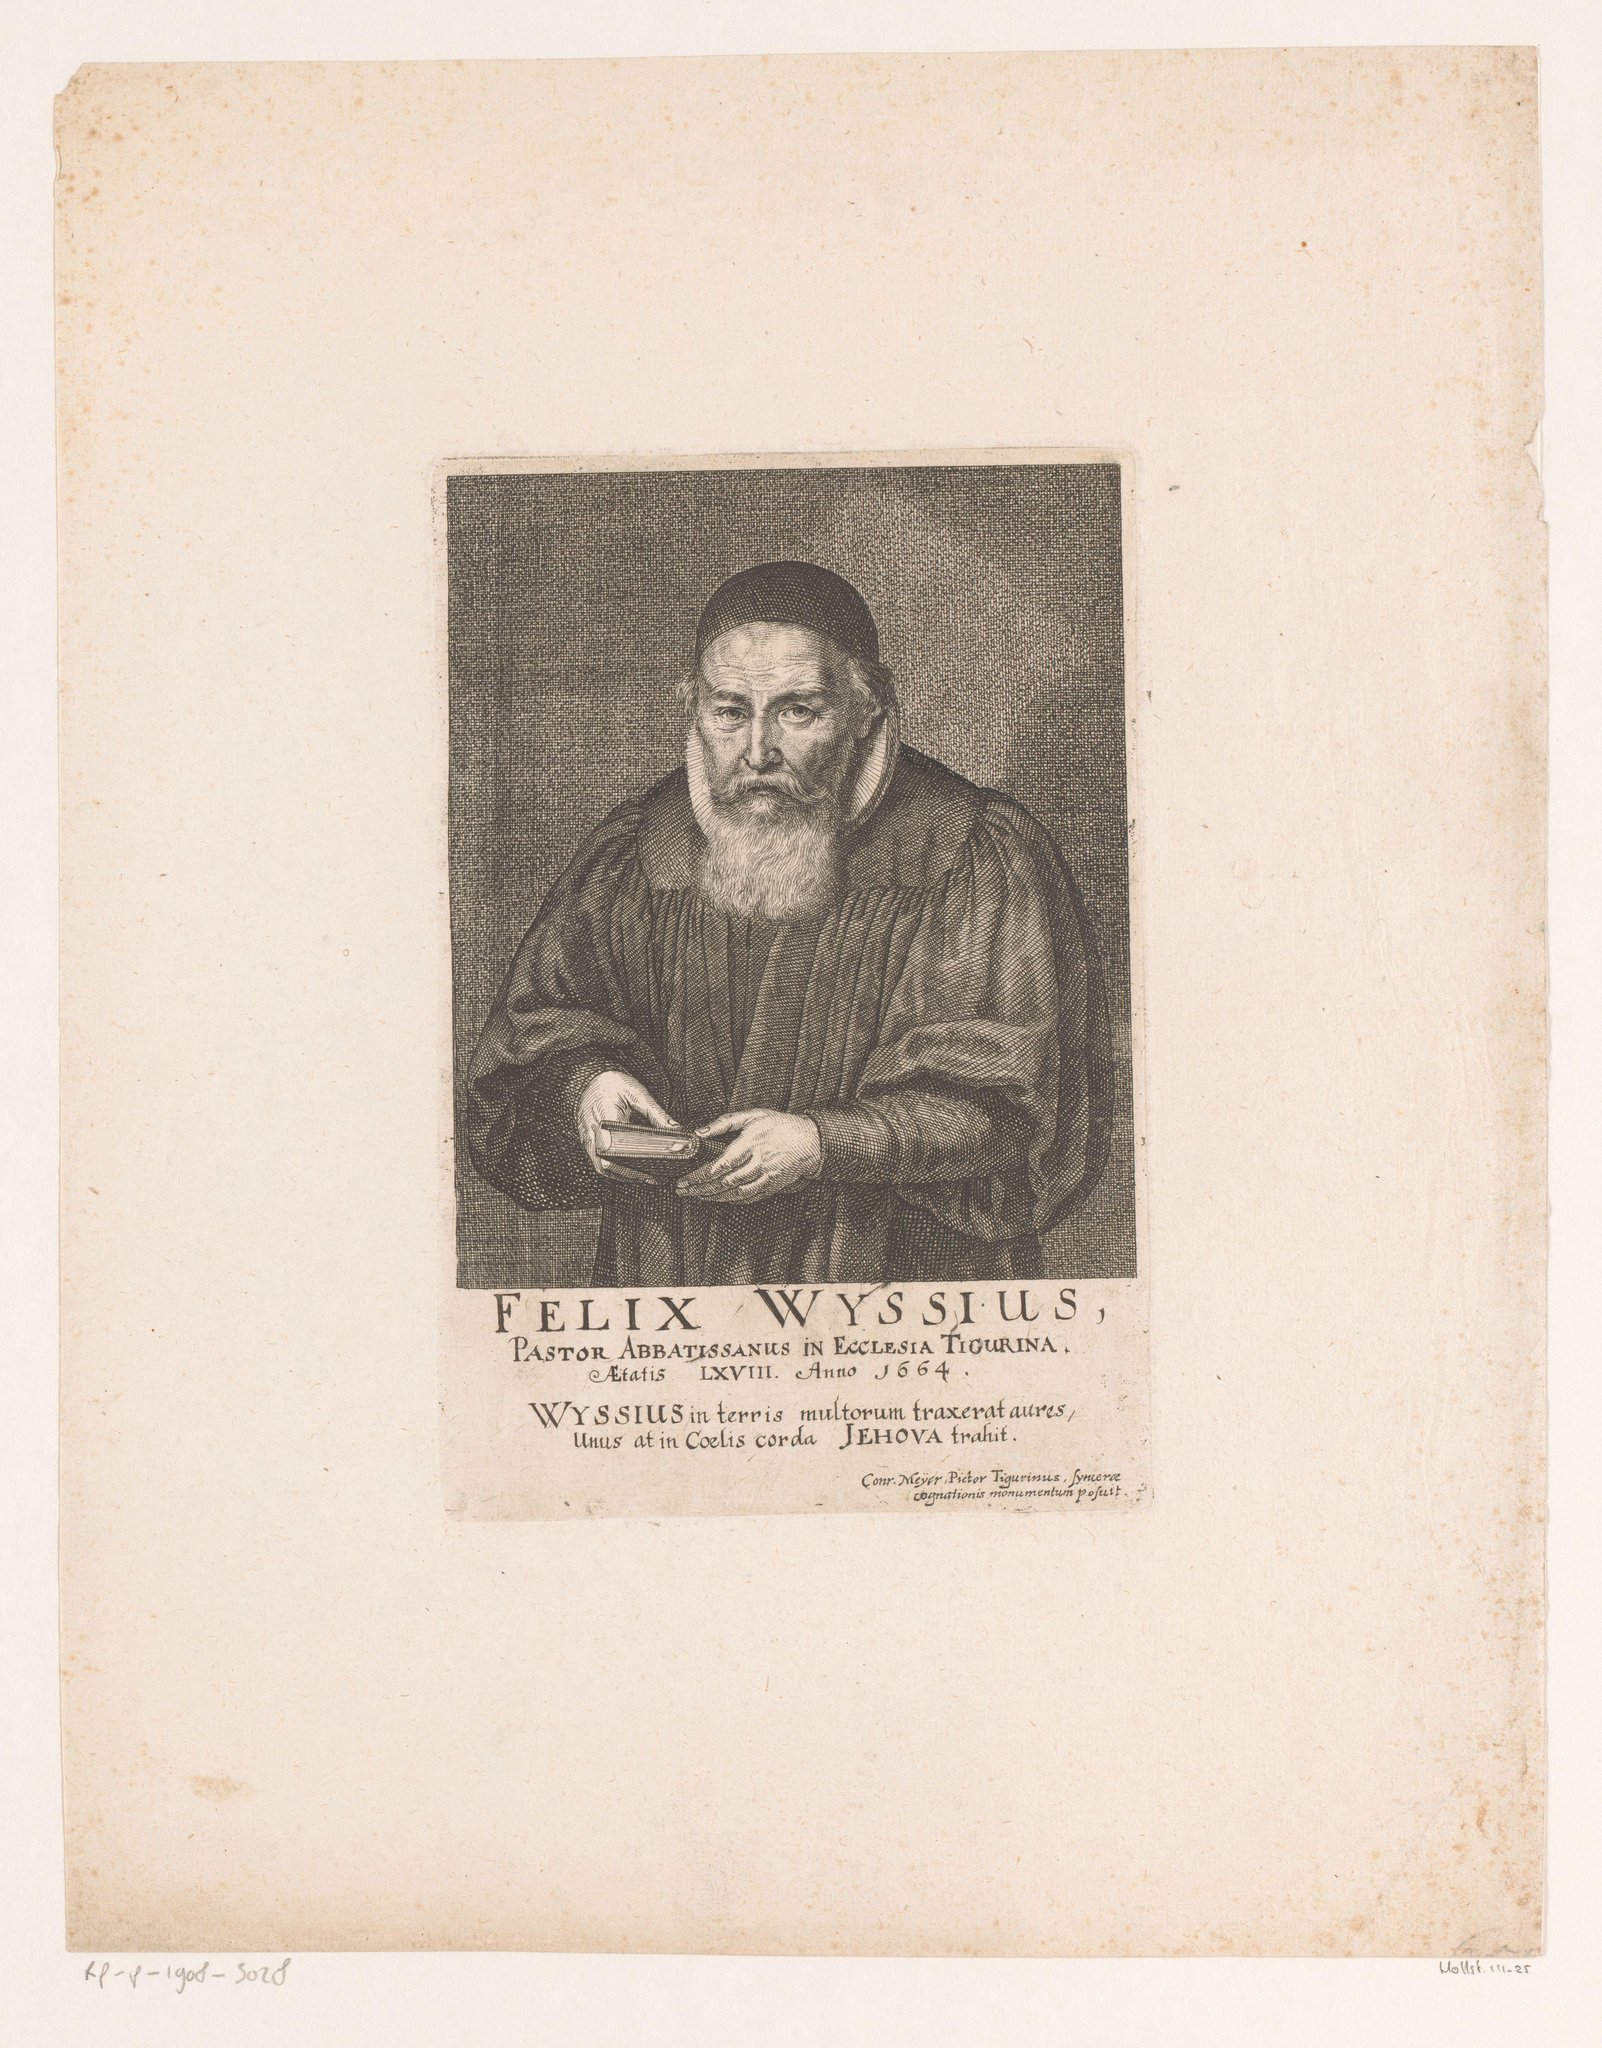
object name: print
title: Portret van Felix Wyss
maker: conrad meyer (i)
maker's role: painter, print maker, publisher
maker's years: 1618-1689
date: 1664-1689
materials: paper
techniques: engraving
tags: theologian, historical persons, book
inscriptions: collector's mark: Lugt 2228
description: Onderdeel van een serie van 62 portretten van priesters en theologen van Zürich. Zie Hollstein German 111, 1-41.